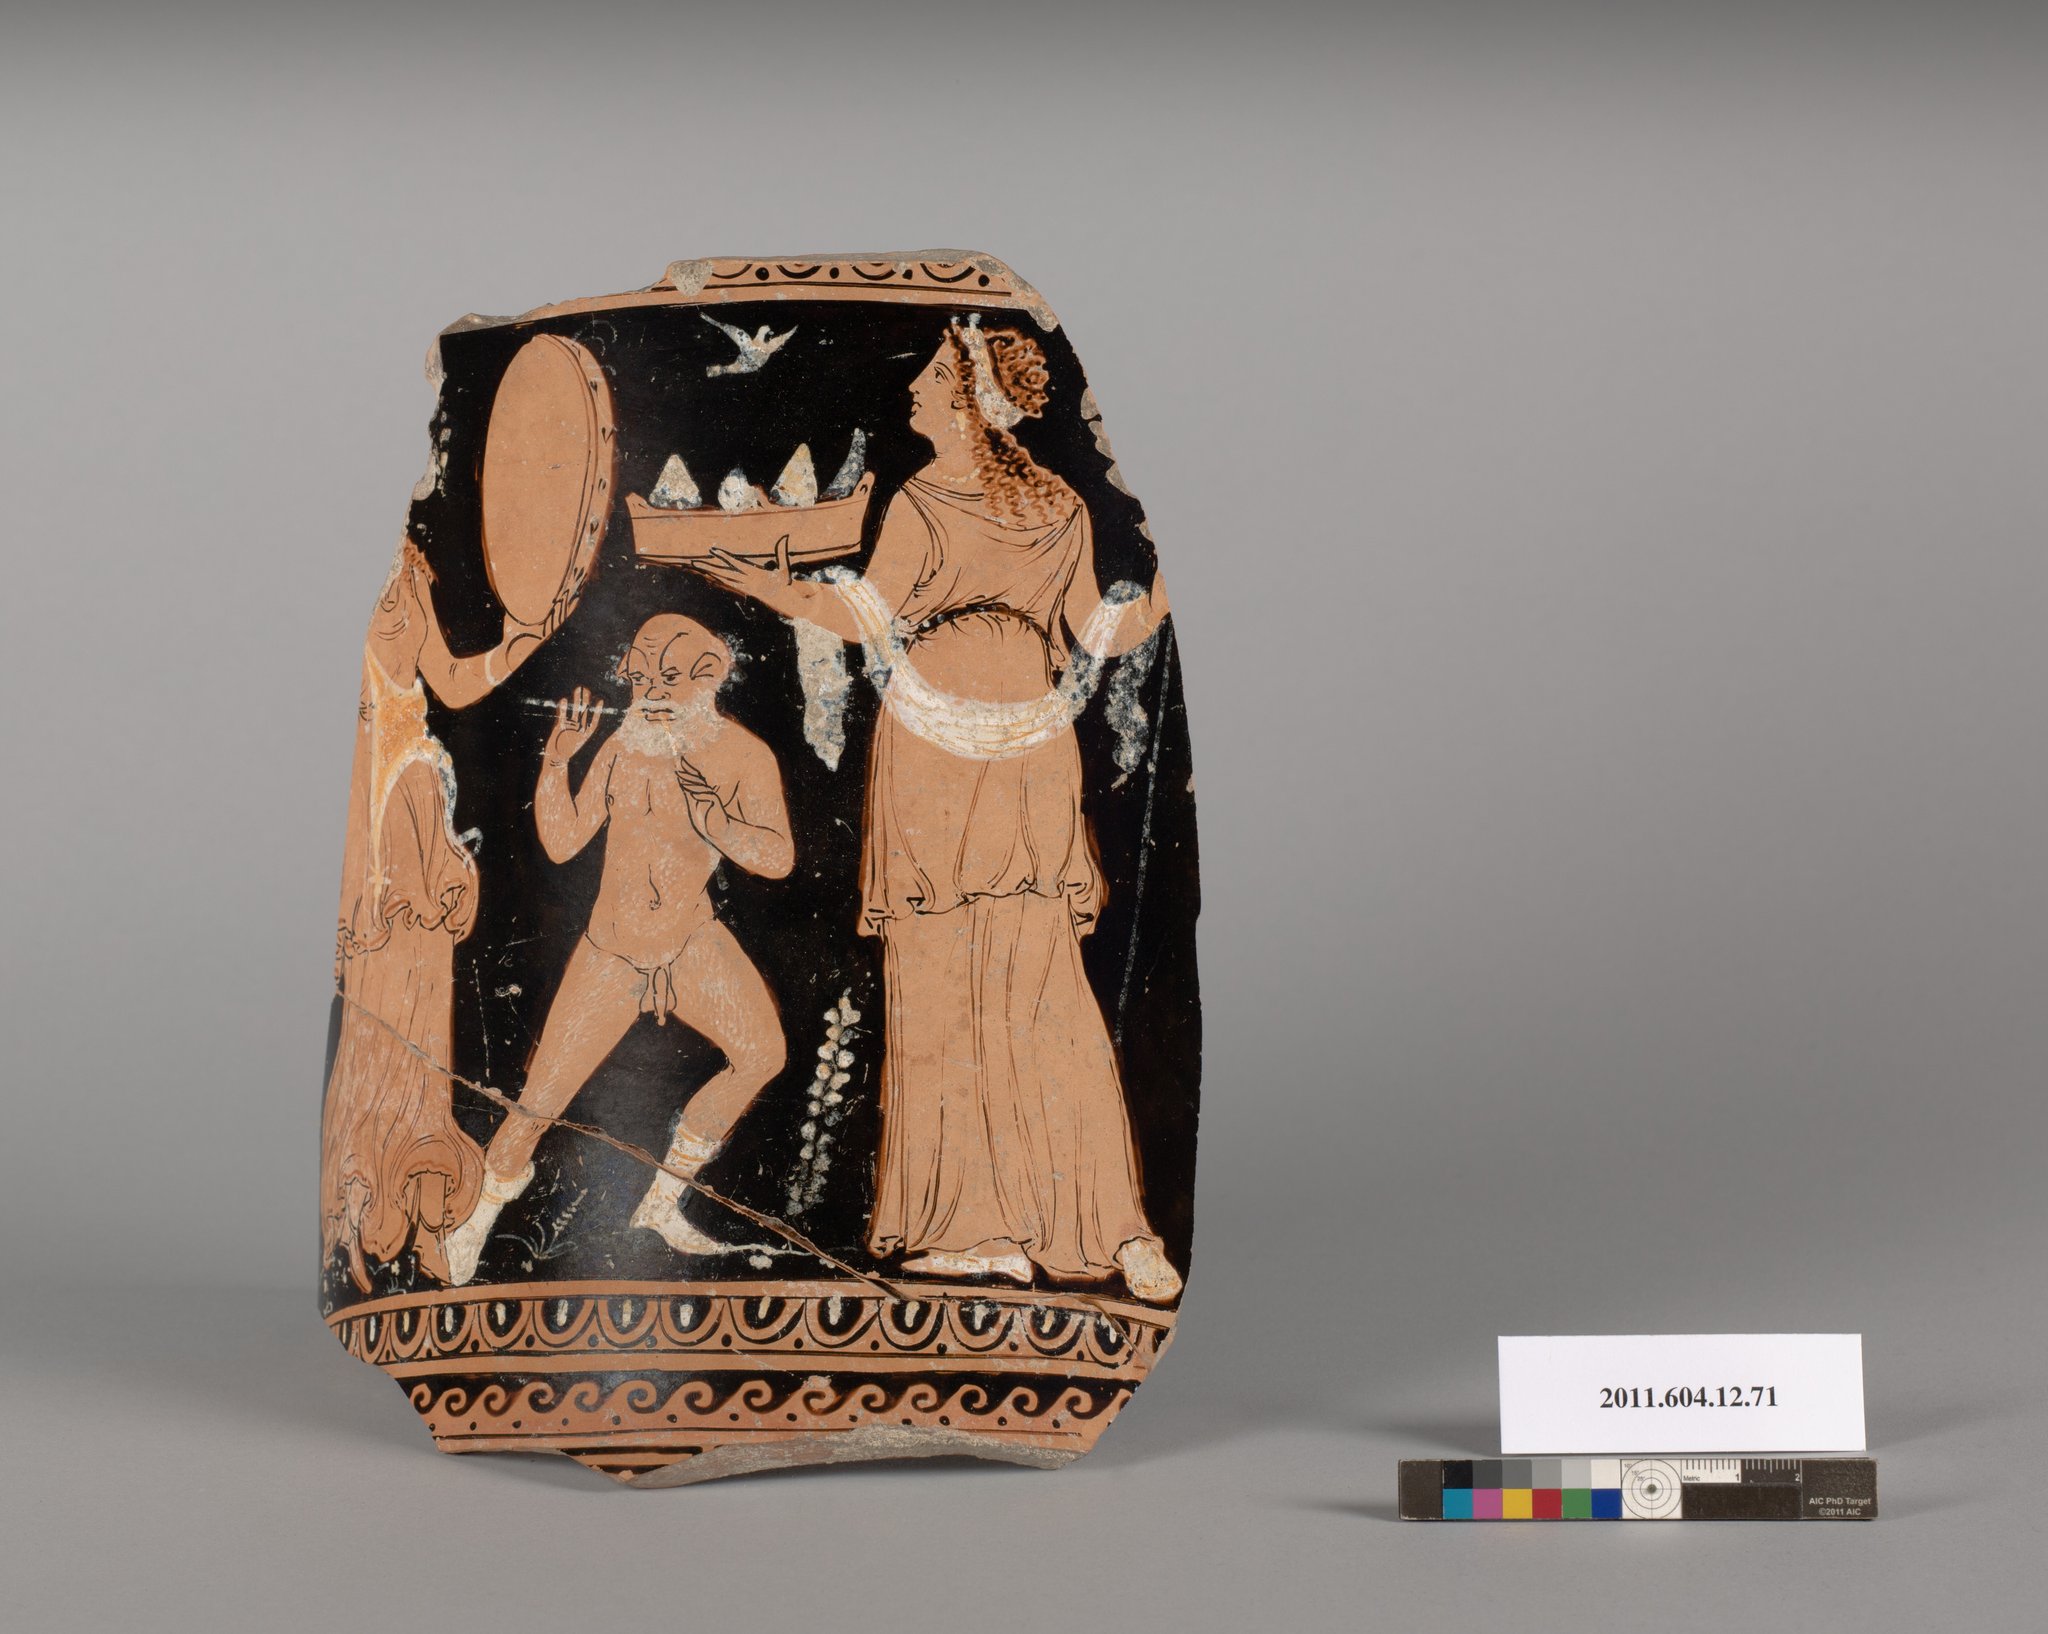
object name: situla fragment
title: Terracotta fragment of a situla (bucket)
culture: greek, sicilian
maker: sicilian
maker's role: artist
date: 400-380 BCE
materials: terracotta